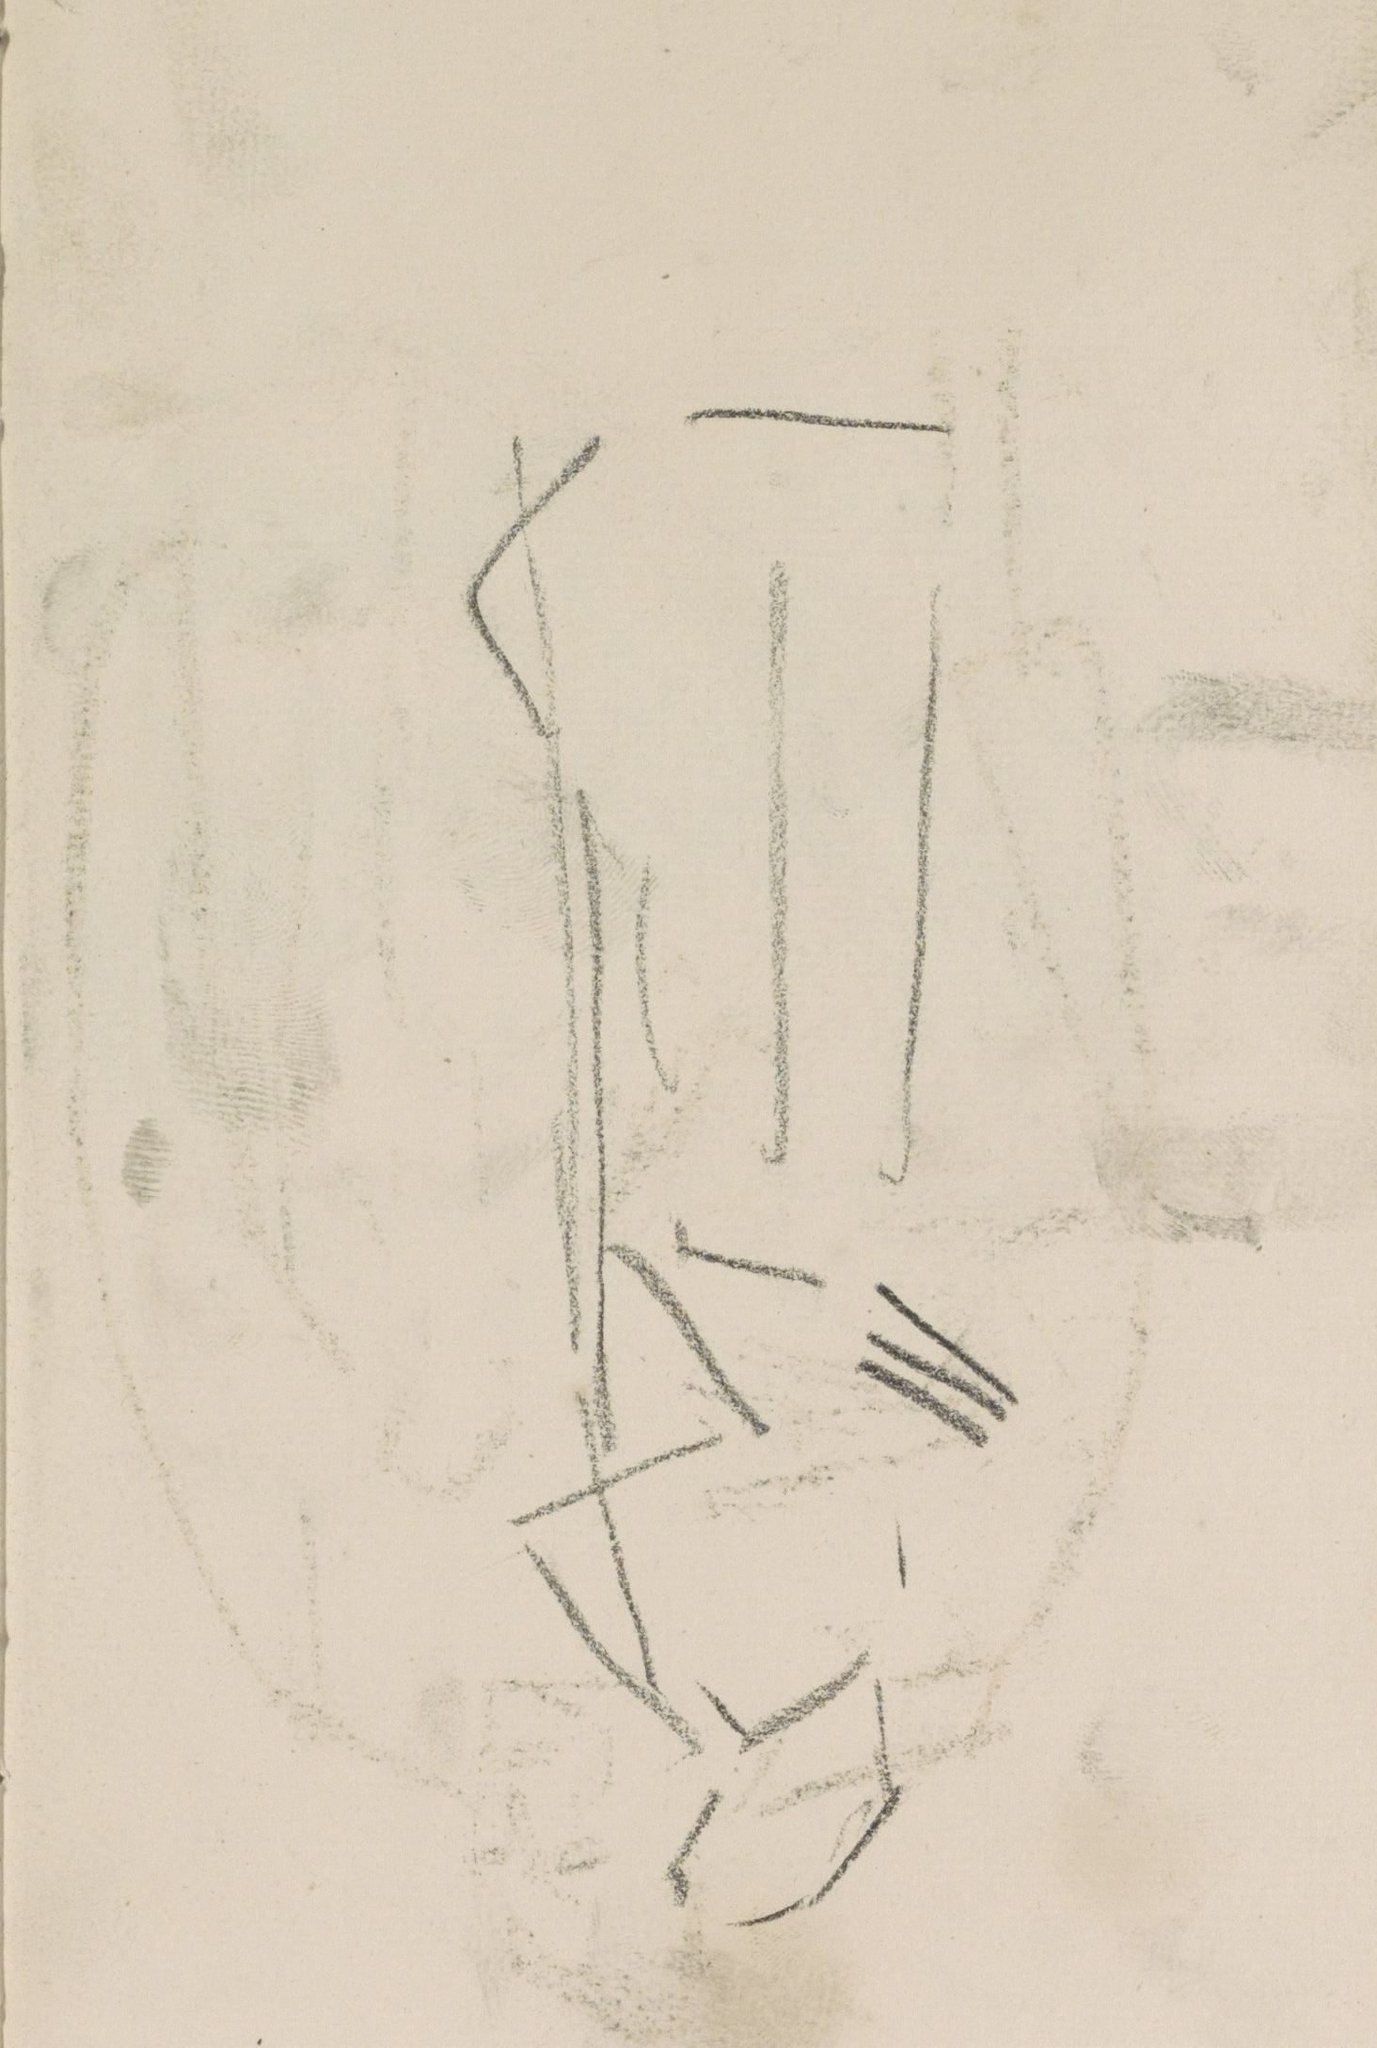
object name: sketchbook leaf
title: Staande vrouw, in profiel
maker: george hendrik breitner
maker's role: draughtsman, painter, print maker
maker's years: 1857-1923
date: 1883-1885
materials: chalk, paper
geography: the hague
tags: adult woman, standing figure - aa - female human figure (+ sideview, profile)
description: Pagina 26 uit een schetsboek met 18 bladen.